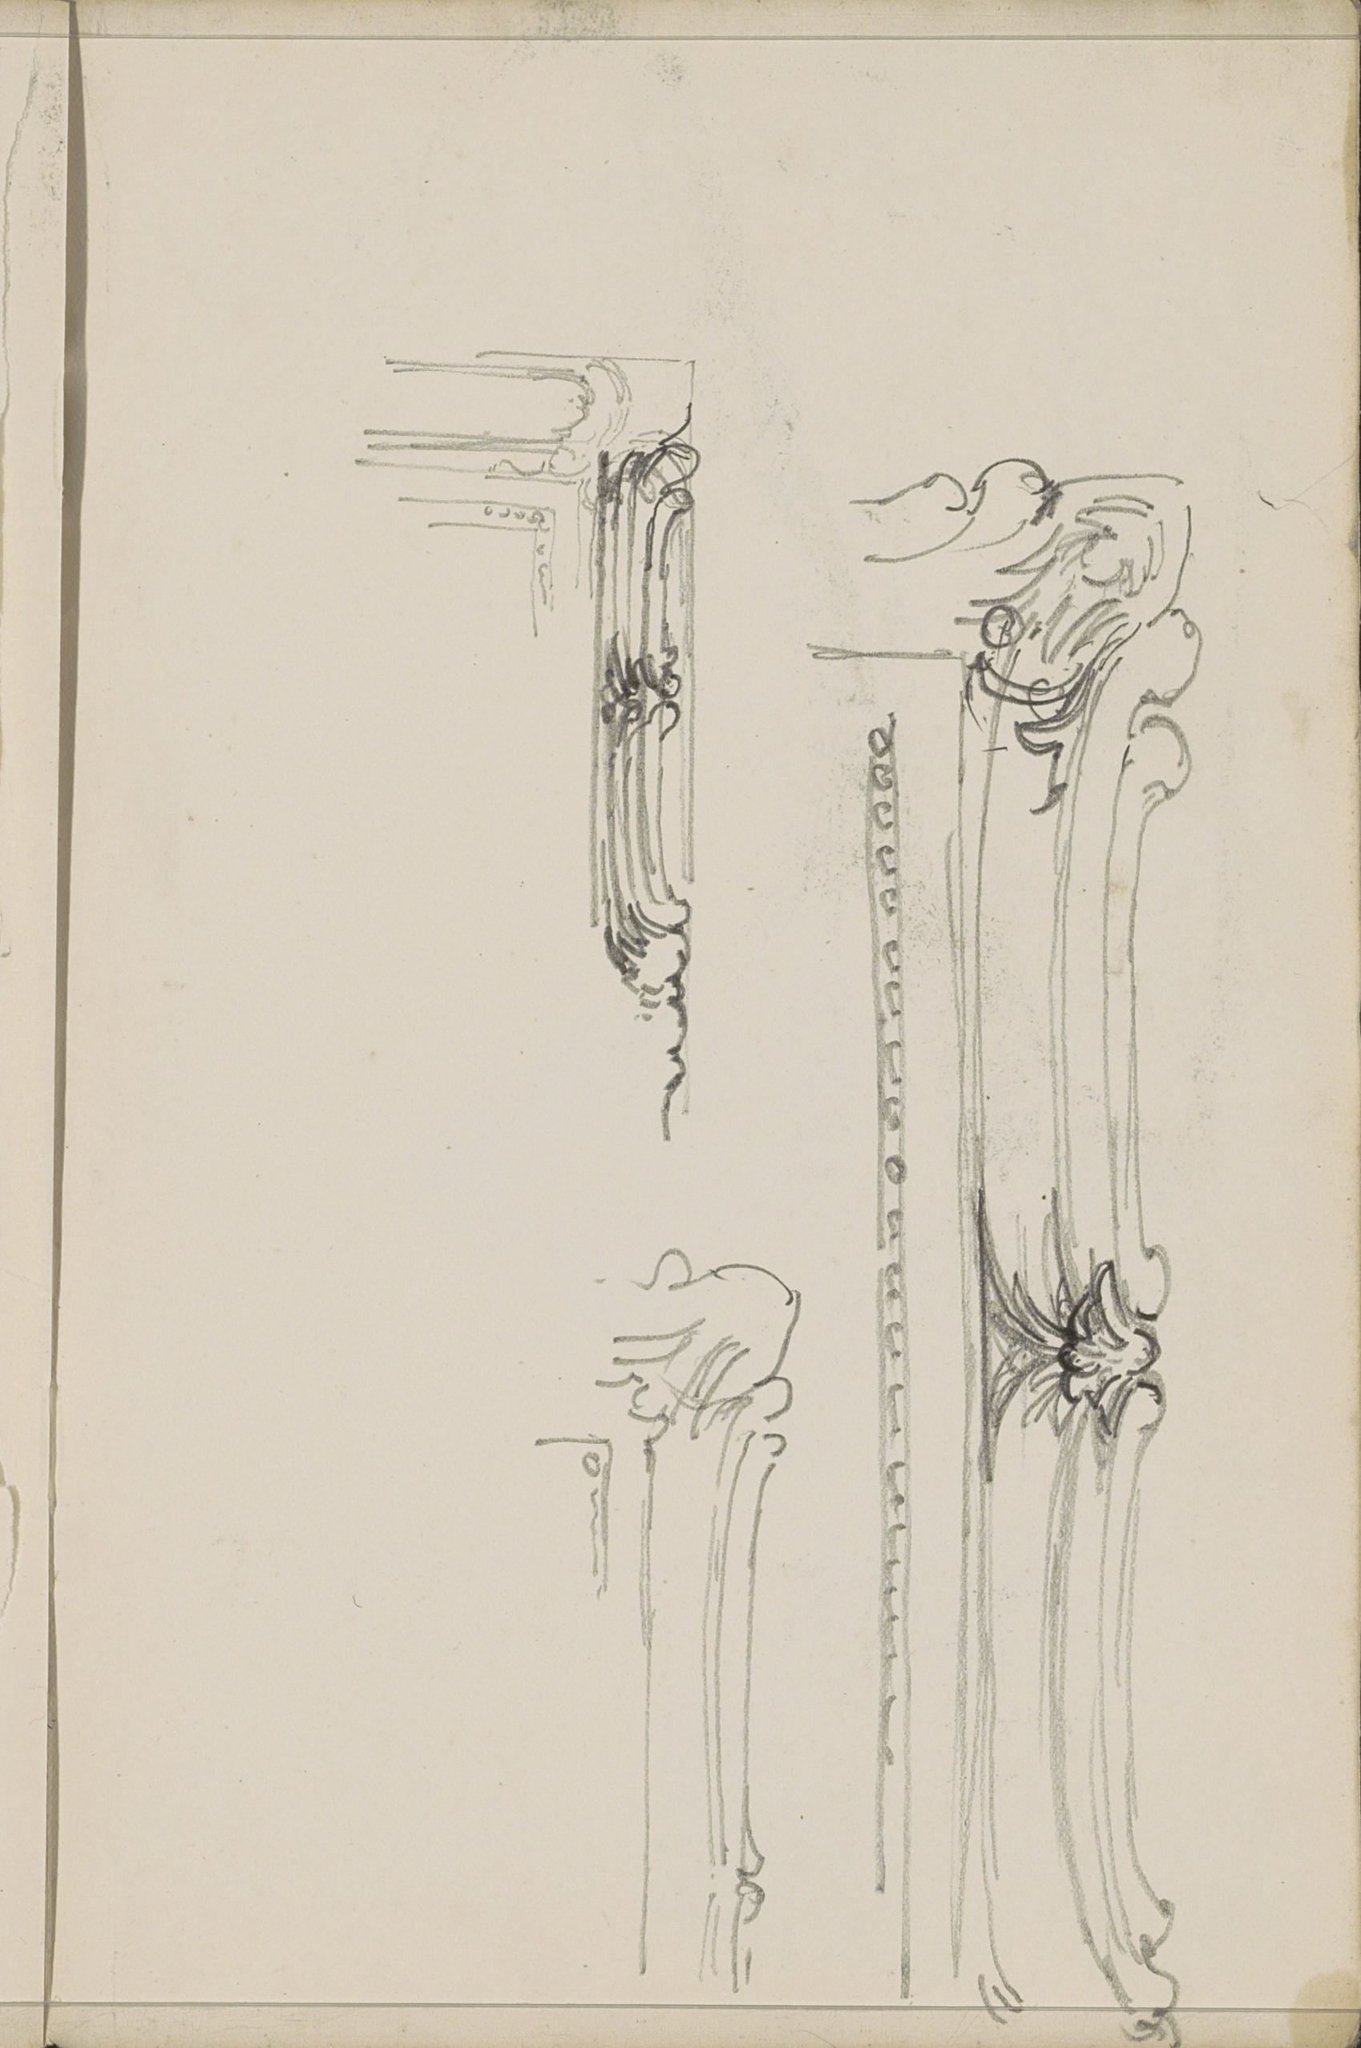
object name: sketchbook leaf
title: Schilderijlijsten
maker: cornelis vreedenburgh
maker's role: draughtsman, print maker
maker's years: 1880-1946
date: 1890-1946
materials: paper, pencil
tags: frame of painting, etc.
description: Blad 45 recto uit een schetsboek met 47 bladen.